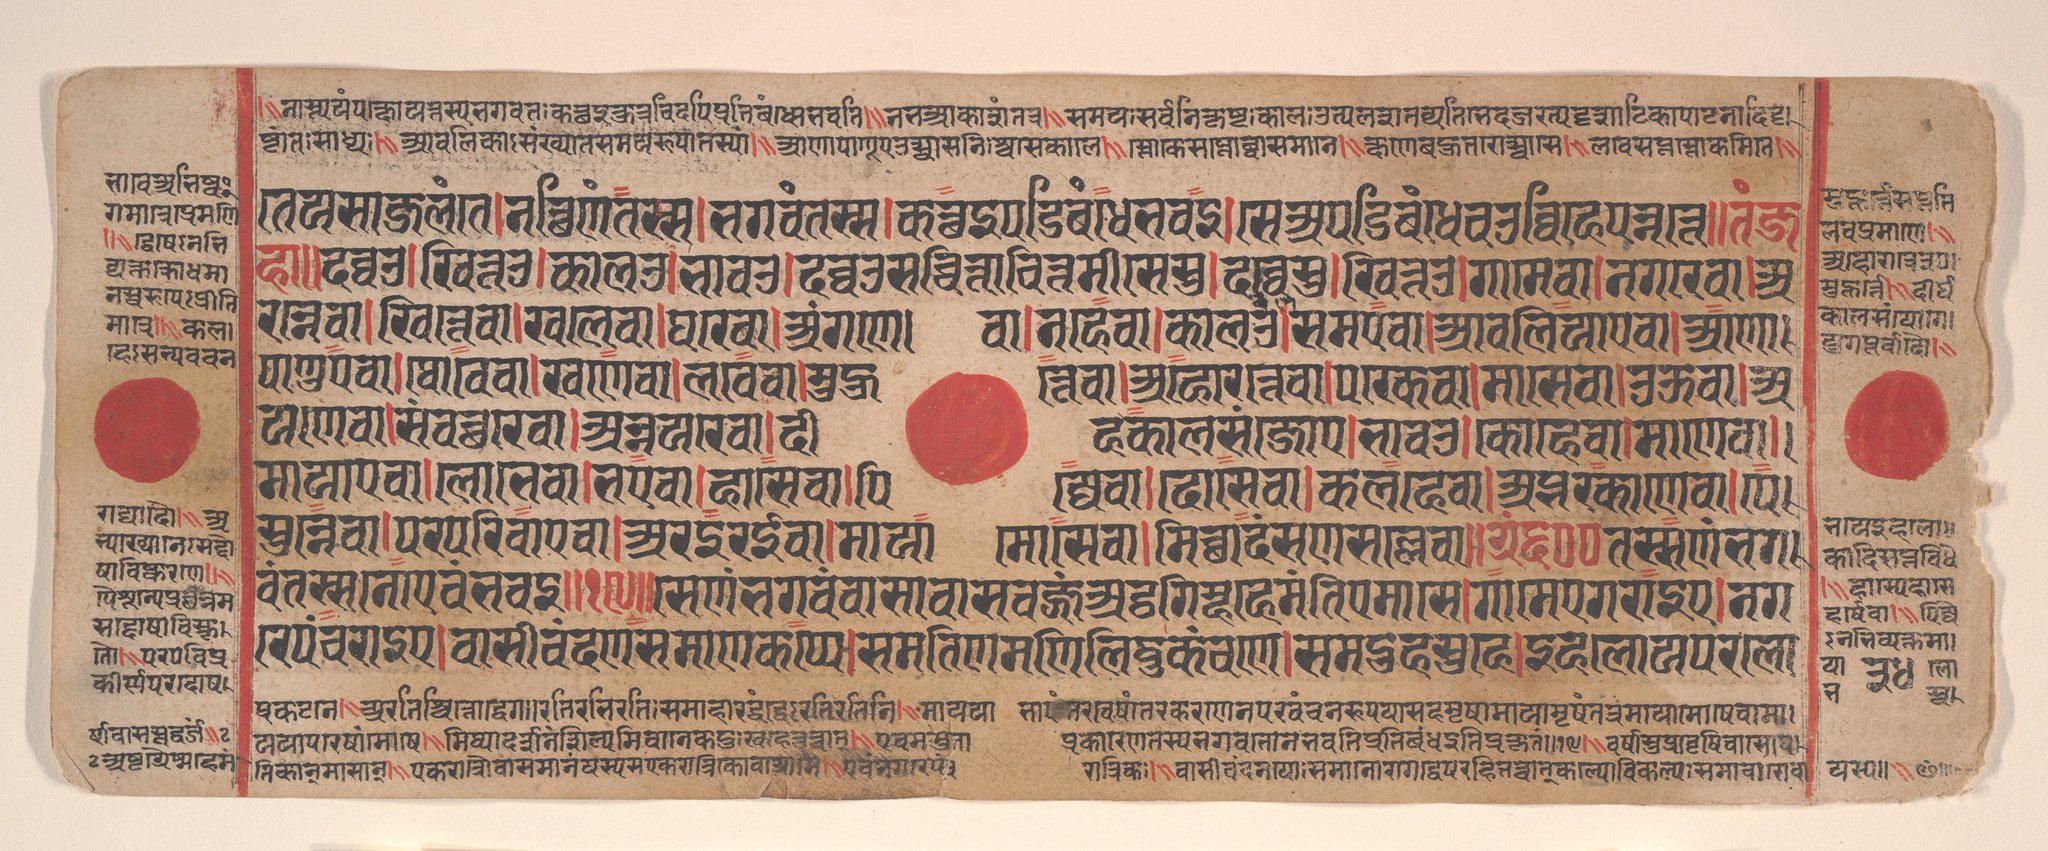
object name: folio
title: Leaf from a Kalpa Sutra (Jain Book of Rituals)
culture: indian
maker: bhadrabahu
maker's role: artist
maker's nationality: indian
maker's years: 356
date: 1401-1500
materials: gold, ink, paper, watercolor